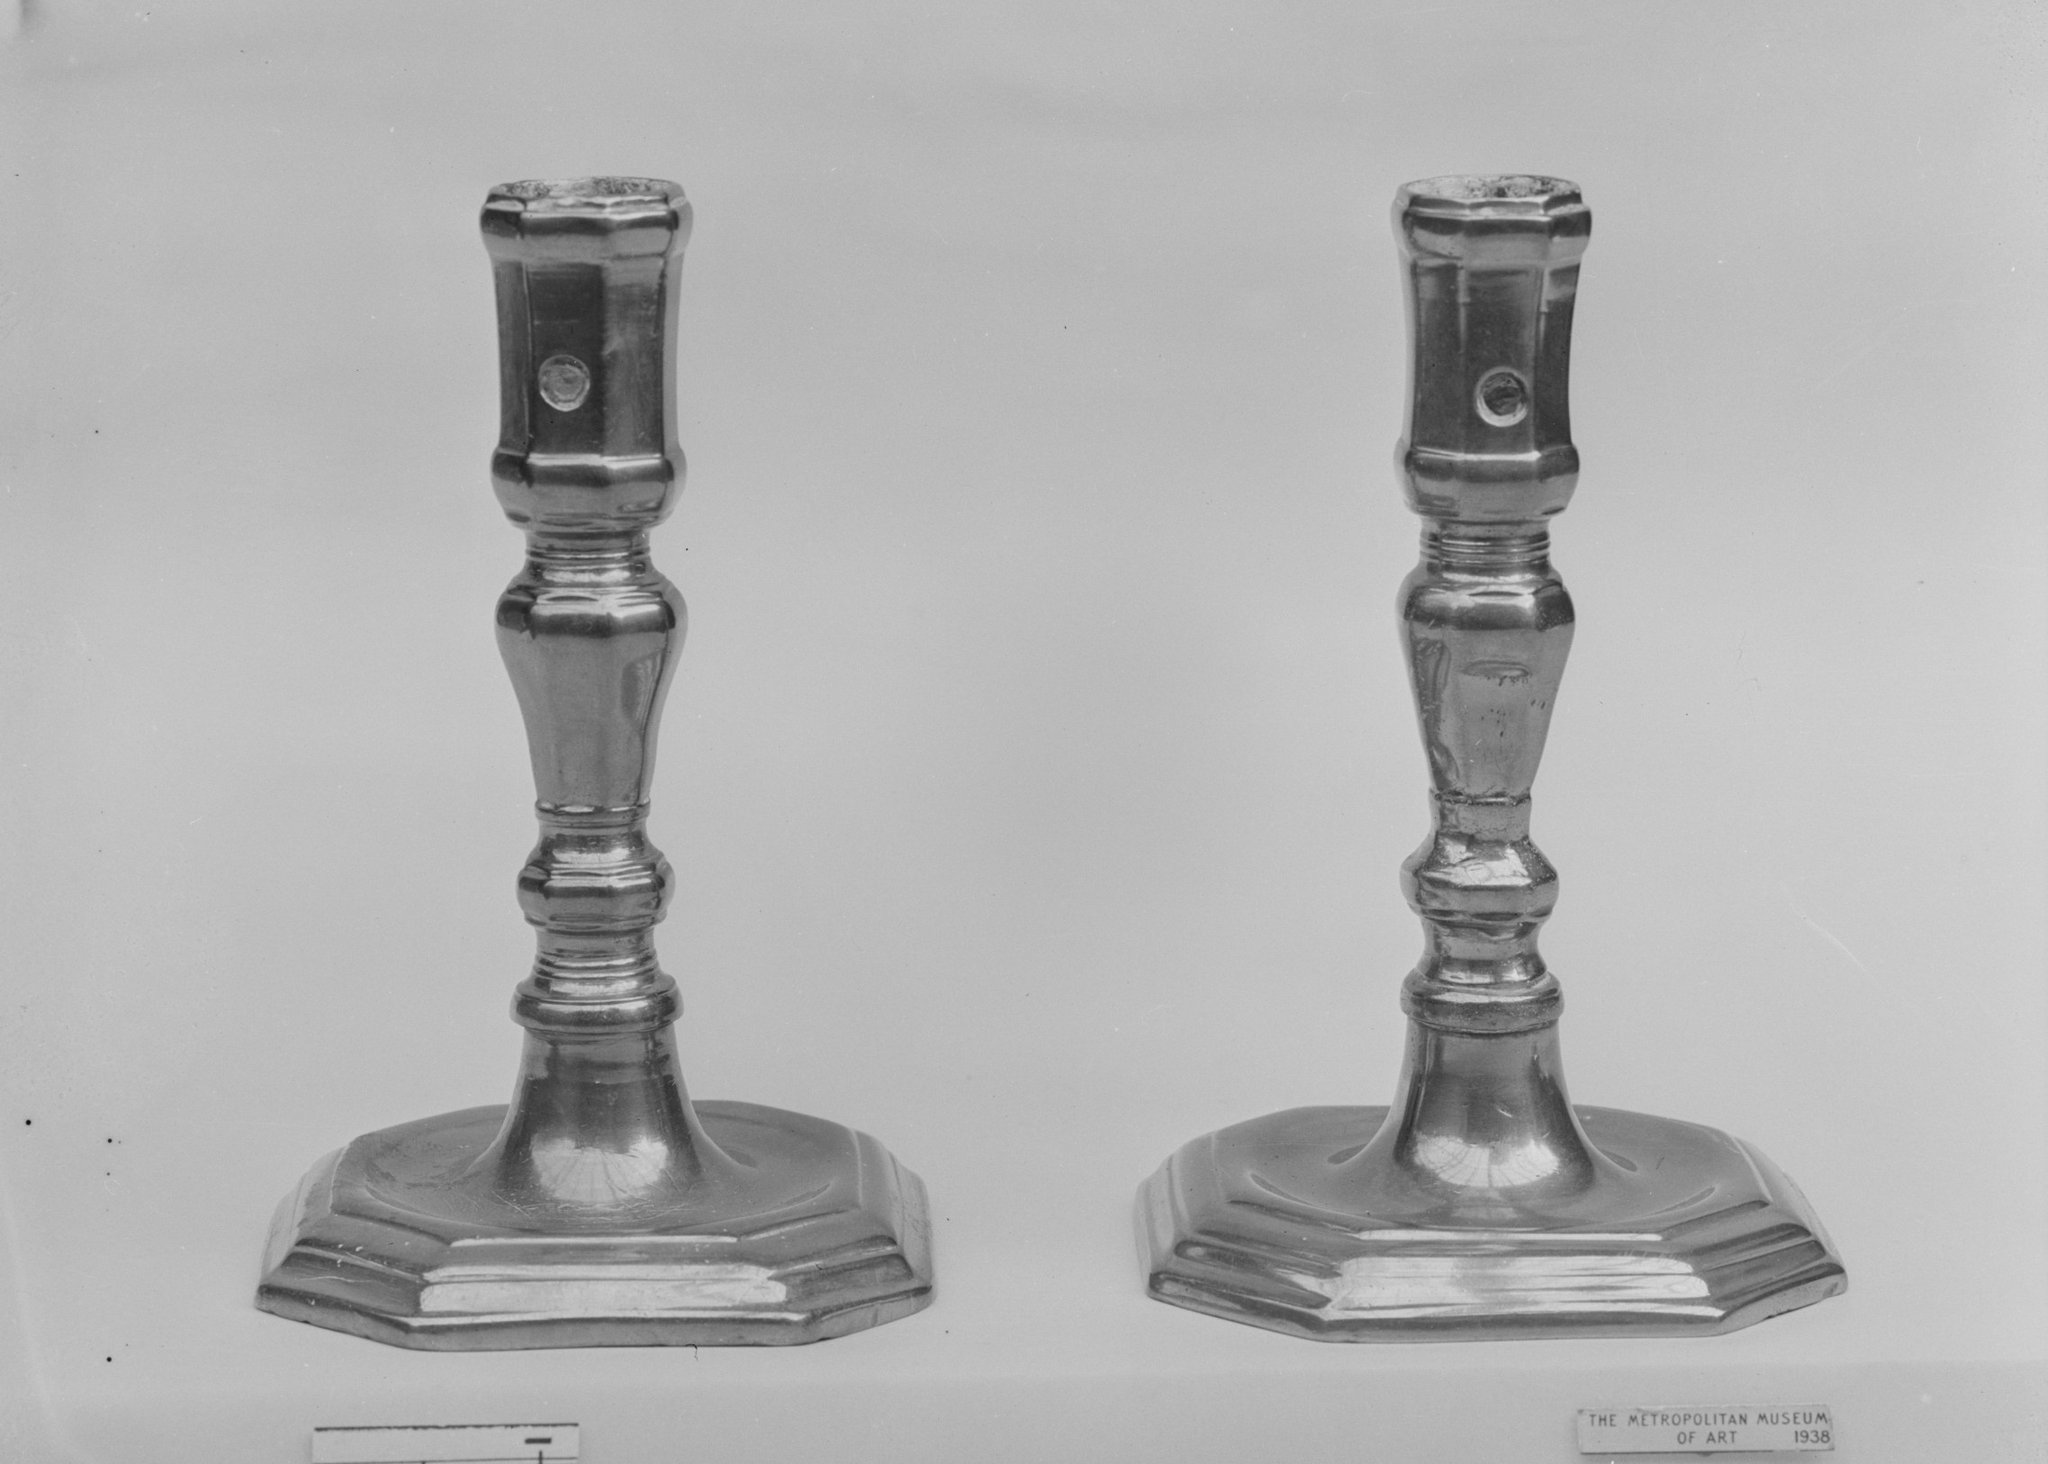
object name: candlestick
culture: american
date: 1720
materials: brass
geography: united states